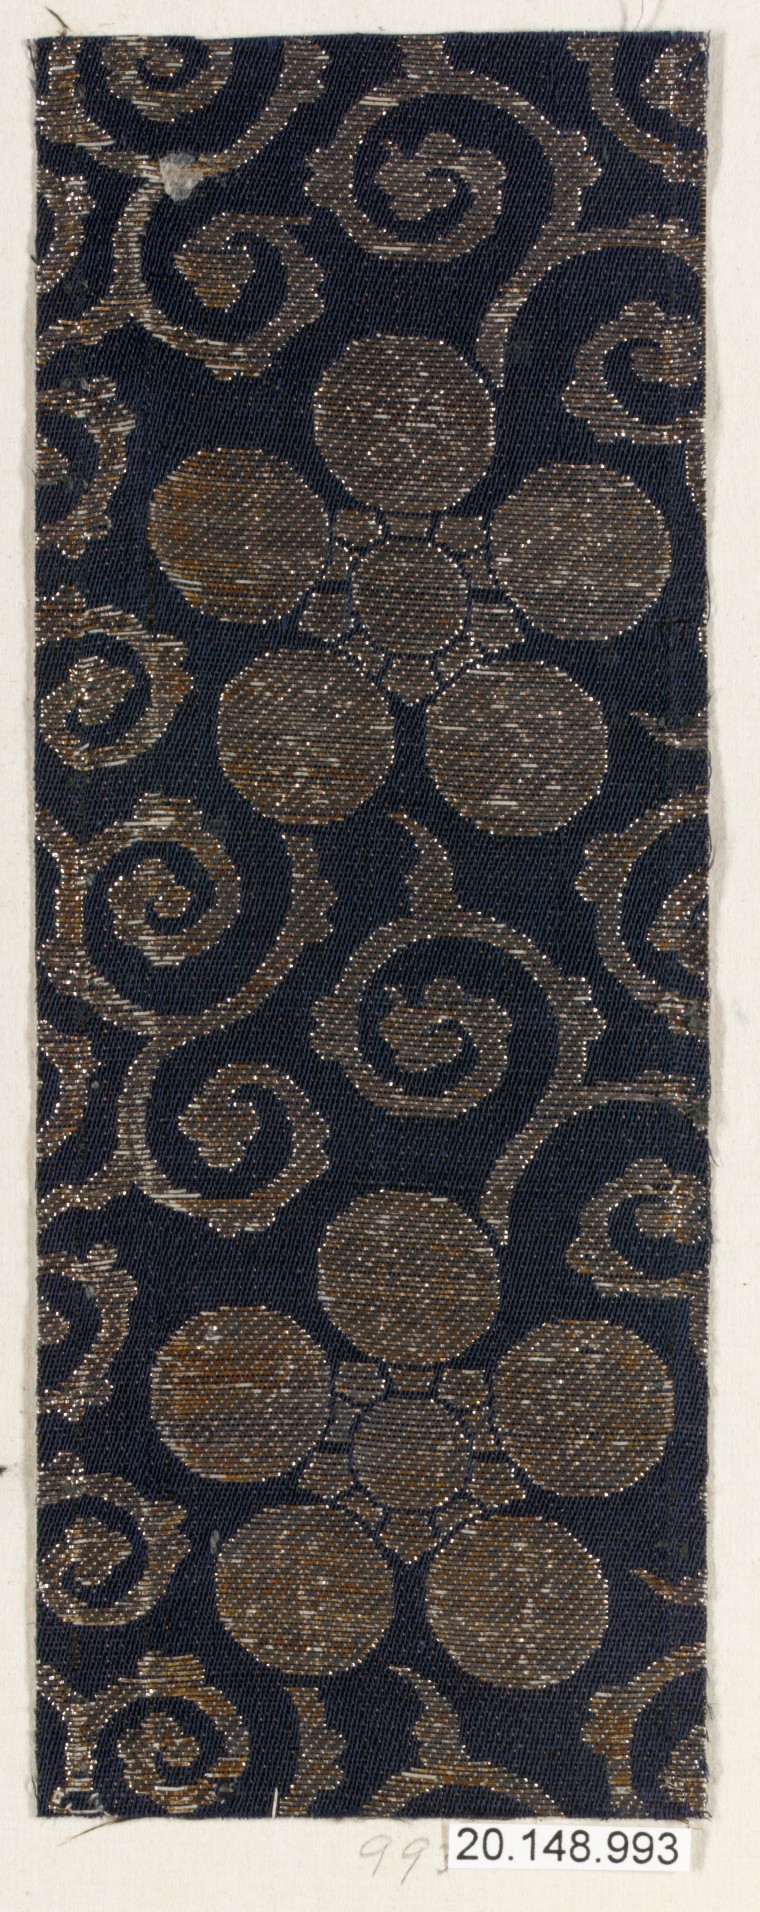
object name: piece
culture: japanese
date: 1601-1700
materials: silk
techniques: compound weave